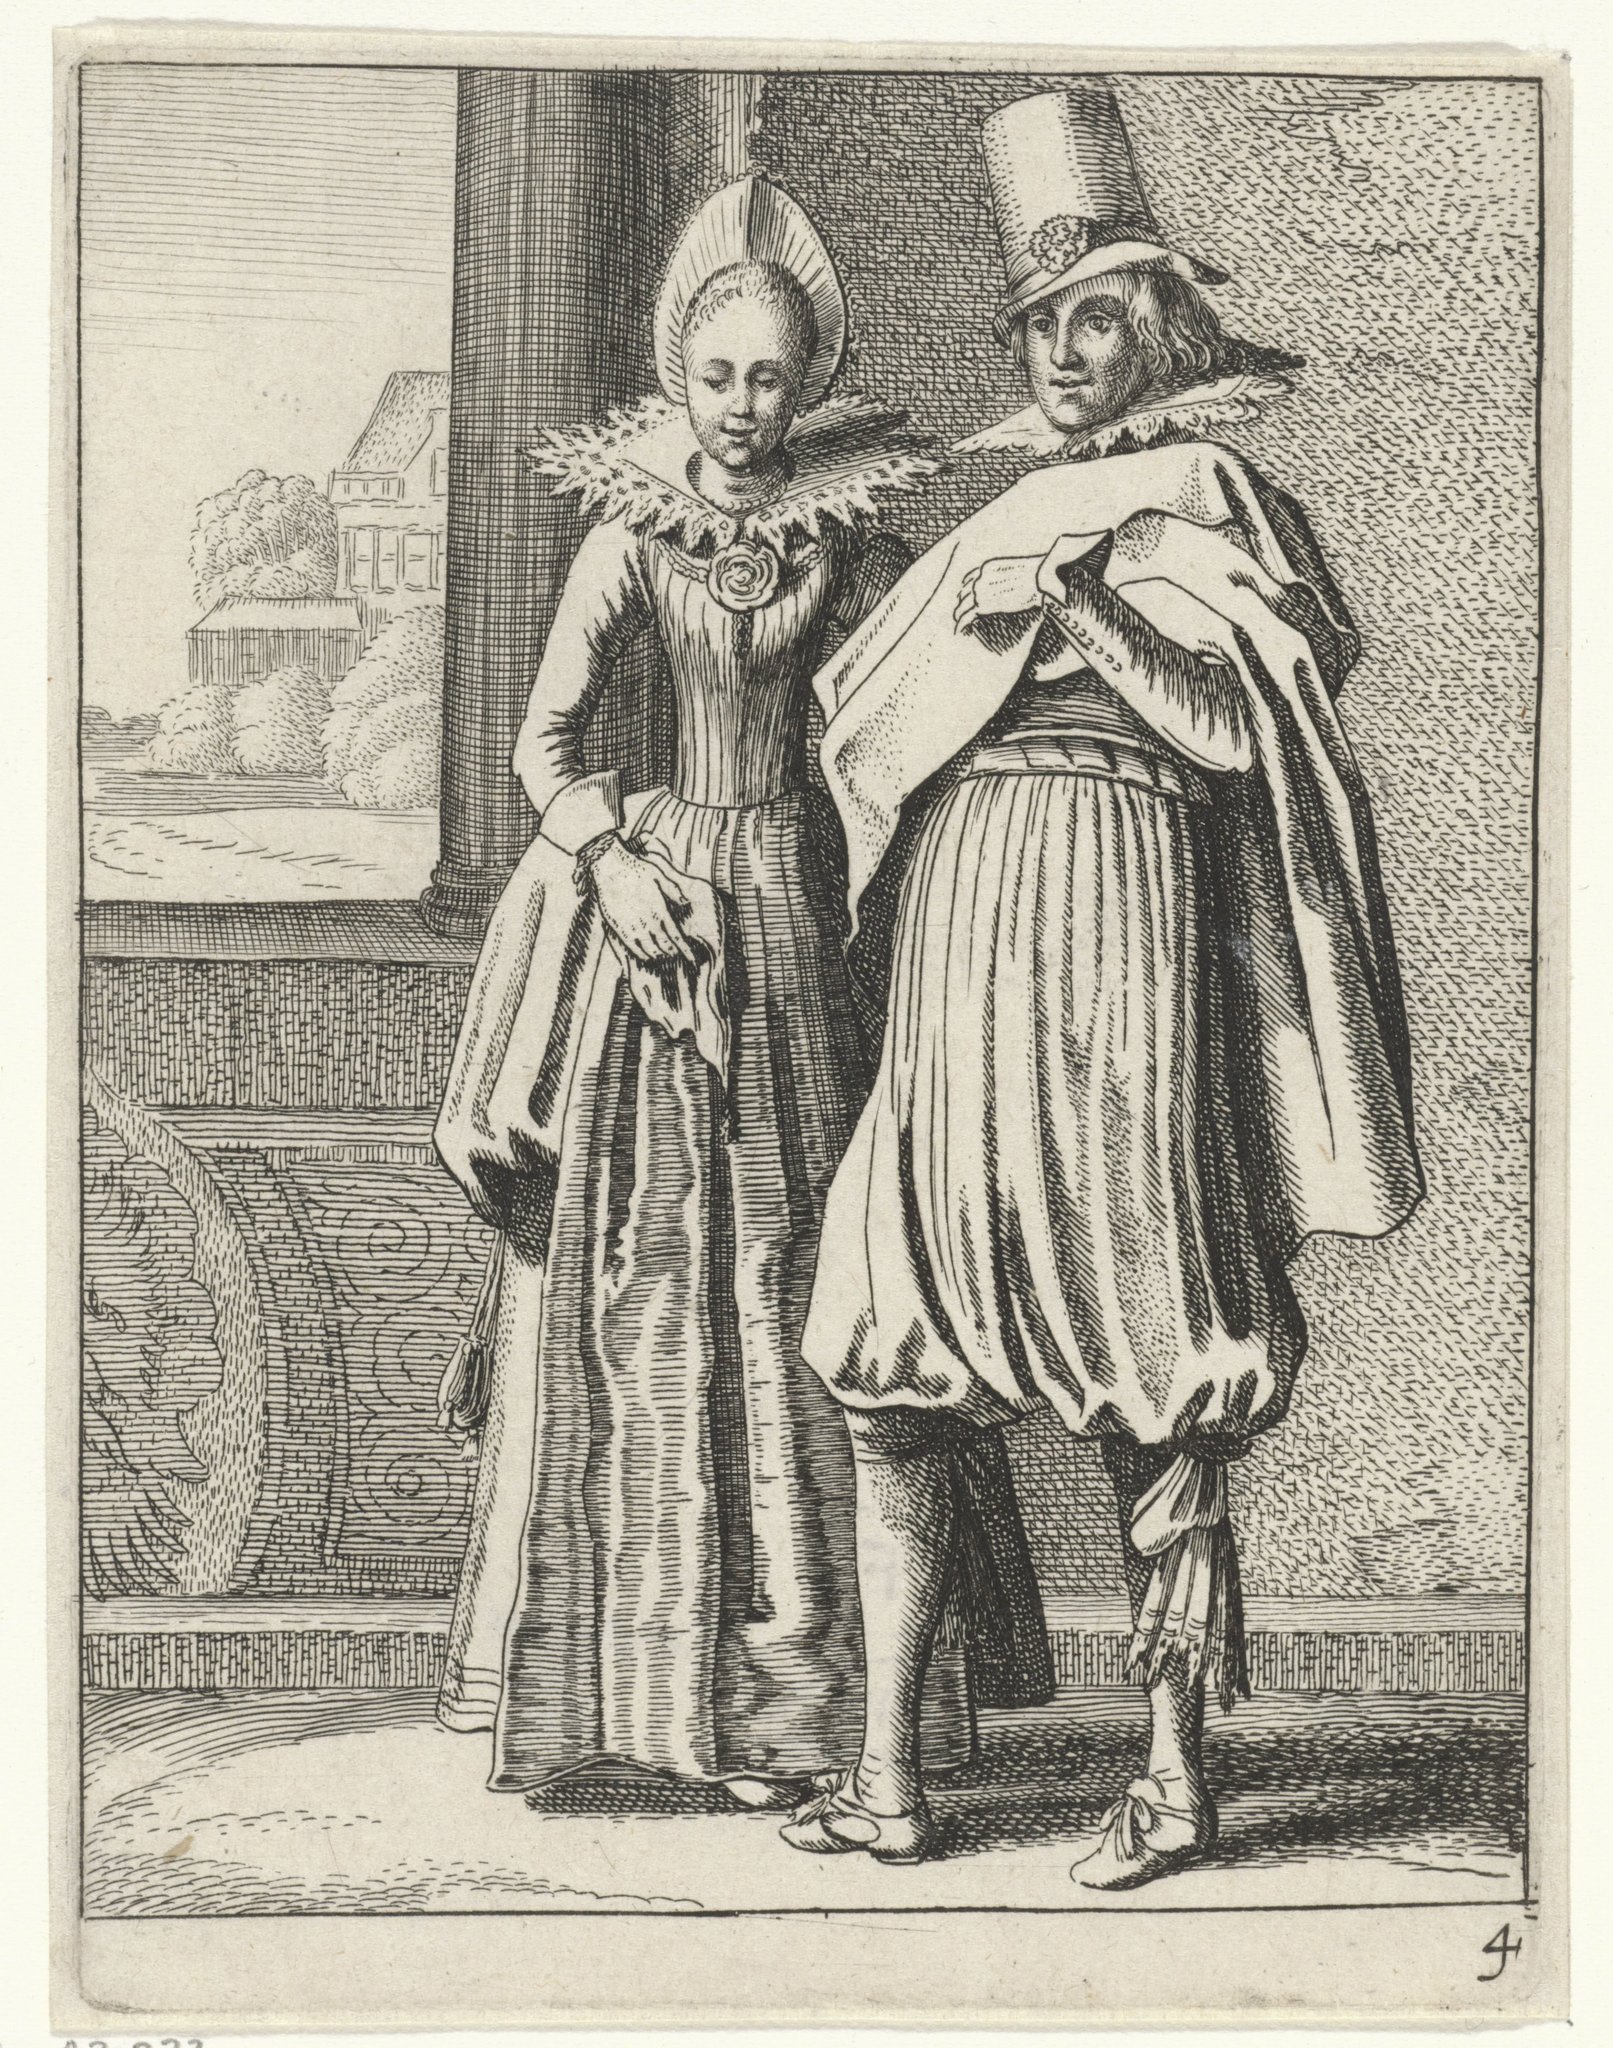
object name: costume print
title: Kostuums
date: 1603-1652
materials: paper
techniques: engraving, etching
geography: amsterdam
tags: brooch, agraffe, clasp (+ women's clothes), coat (+ men's clothes), head-gear (boogmuts) (+ women's clothes), head-gear: hat (+ men's clothes), neck-gear: collar (+ women's clothes), clothes, costume (+ women's clothes), skirt (+ women's clothes), sleeves: cuffs (+ women's clothes), dress, gown (+ women's clothes), shoes, sandals (+ men's clothes), clothes, costume (+ men's clothes), neck-gear: collar (+ men's clothes), stockings, socks (+ men's clothes), sleeves (+ women's clothes), clothing for the upper part of the body (with name) (+ women's clothes)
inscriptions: number: ‘4’, collector's mark: Lugt 964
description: Kleding man: hoed met cilindervormige bol, kraag met kant, kort wambuis, tot de taille reikend, waaroverheen losse schoudermantel; kniebroek met strikken. Schoenen met lage hak en striksluiting. Vrouw: diadeemmutsje. Waaiervormige dichte kraag met kant. Kort lijfje met knopen en rozet. Opgeslagen rok. Zakdoek in de hand.